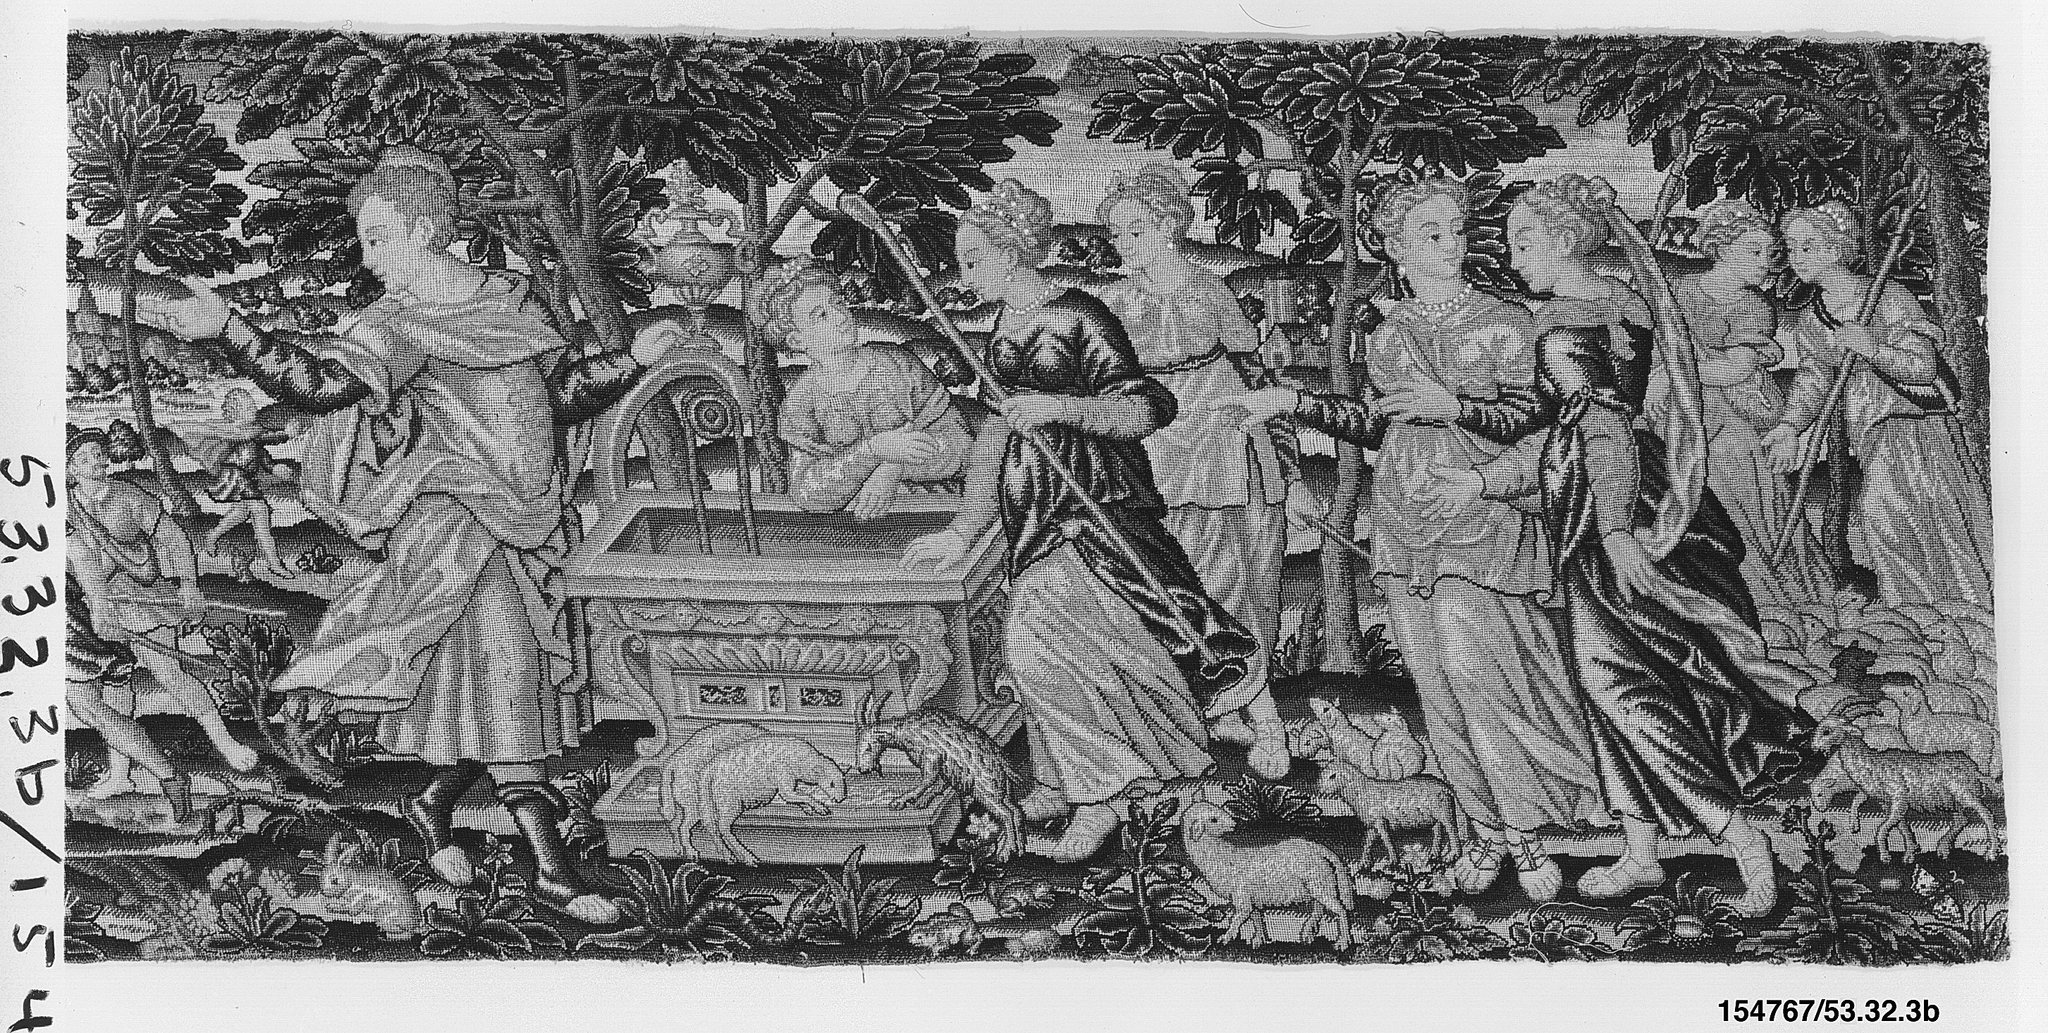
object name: panel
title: Valance with The Story of Moses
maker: bernard salomon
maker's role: artist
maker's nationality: french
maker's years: 1508-1561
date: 1600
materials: canvas, silk, wool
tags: women,sheep,moses